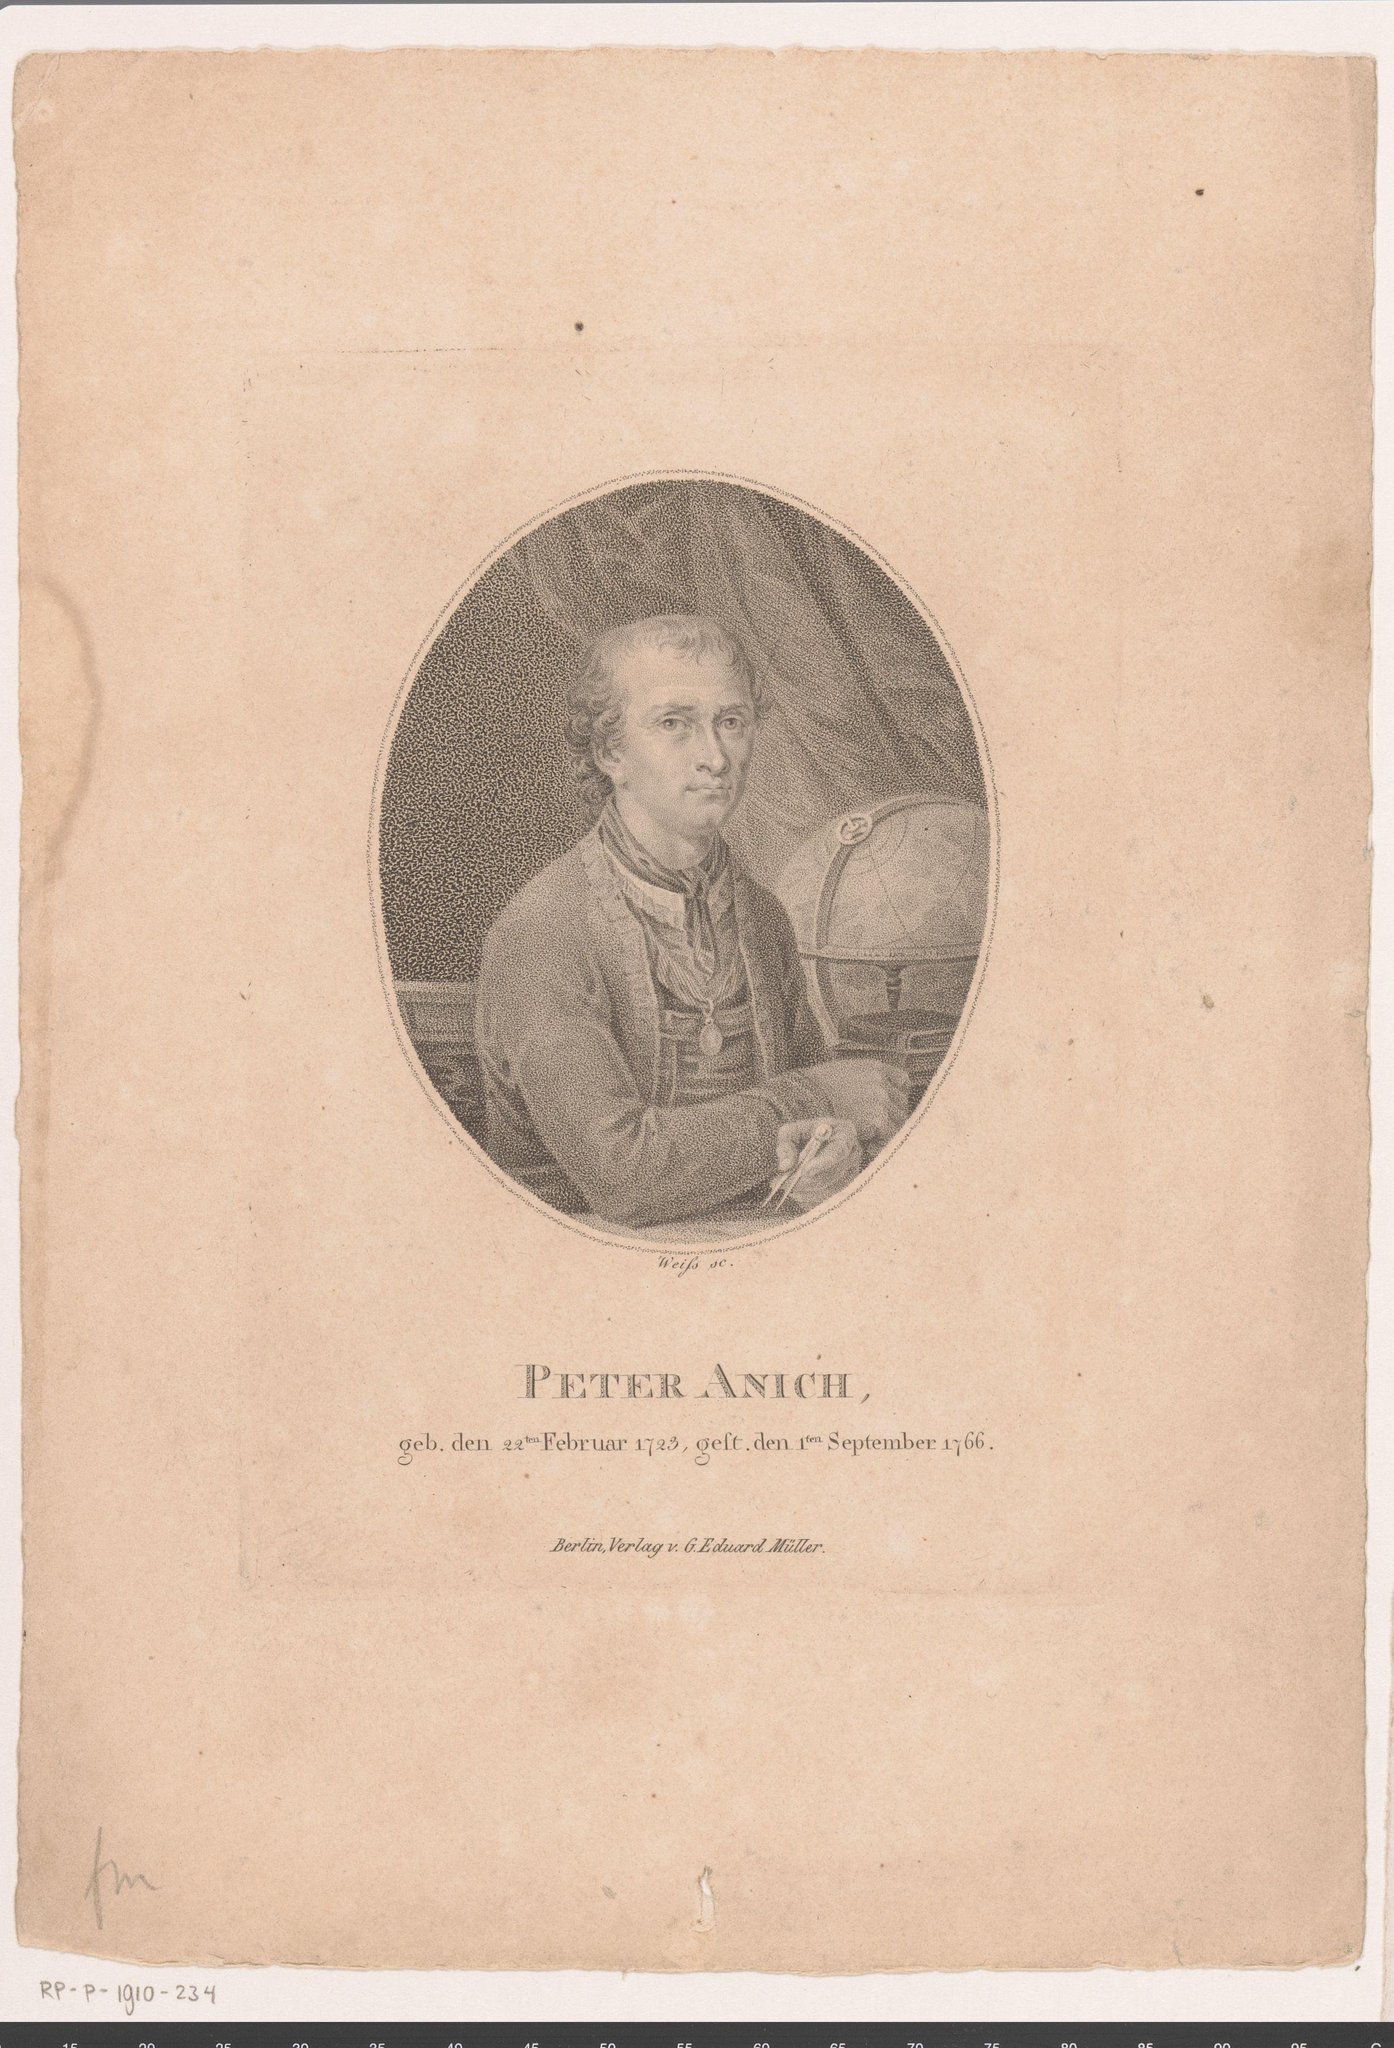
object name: print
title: Portret van Peter Anich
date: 1785-1846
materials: paper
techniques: engraving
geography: berlin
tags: historical persons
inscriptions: collector's mark: Lugt 2228